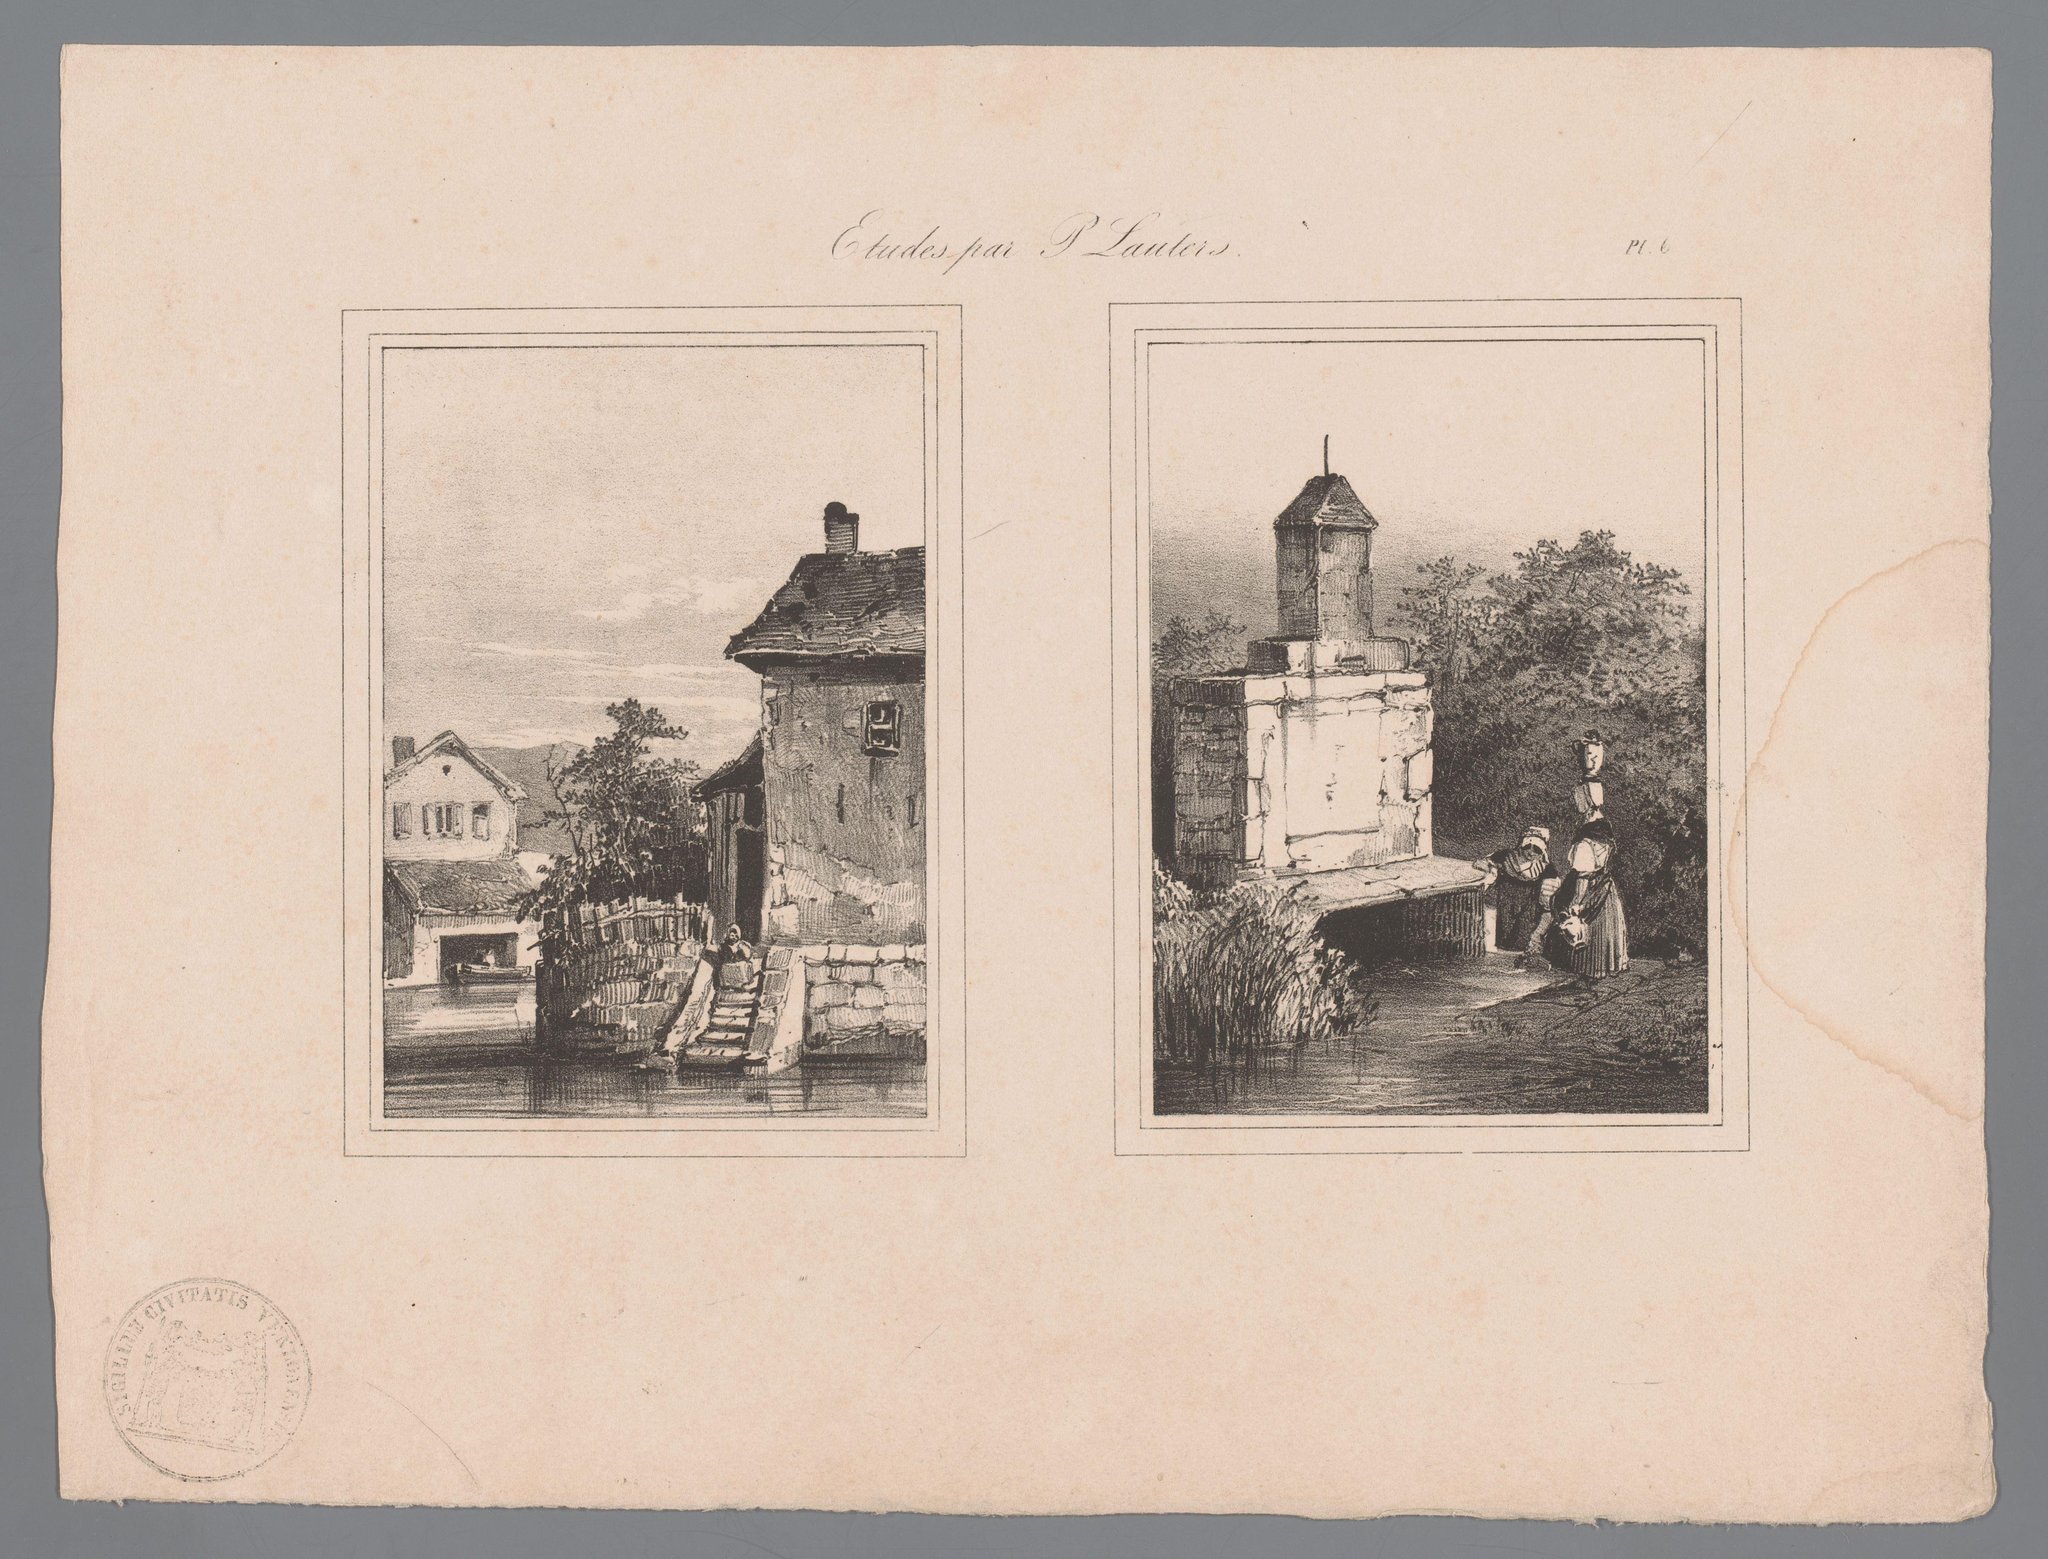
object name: print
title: Dorpsgezicht en twee vrouwen bij een bron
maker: paulus lauters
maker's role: print maker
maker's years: 1806-1875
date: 1832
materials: paper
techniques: lithograph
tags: well, canals, waters (in village)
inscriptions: collector's mark: ‘Sigillum Civitatis Venlonessis’, collector's mark: Lugt 2228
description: Prent maakt deel uit van een serie landschappen van een onbekend aantal prenten. De hoogst genummerde prent uit deze serie in de collectie Rijksmuseum Amsterdam heeft nummer 74.